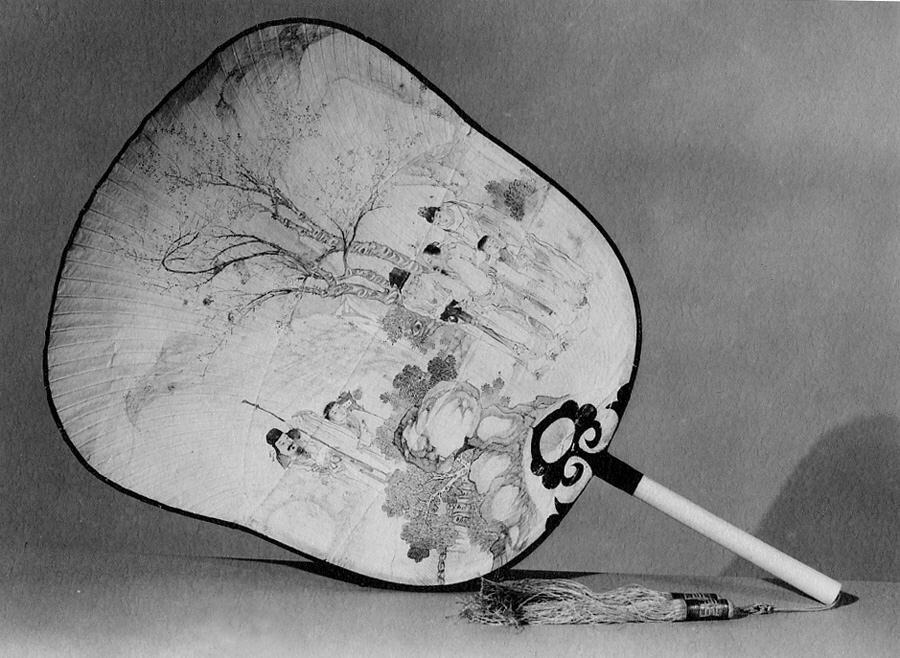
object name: fan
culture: chinese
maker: unidentified artist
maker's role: artist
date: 1736-1795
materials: bamboo, ivory, paper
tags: boys,men